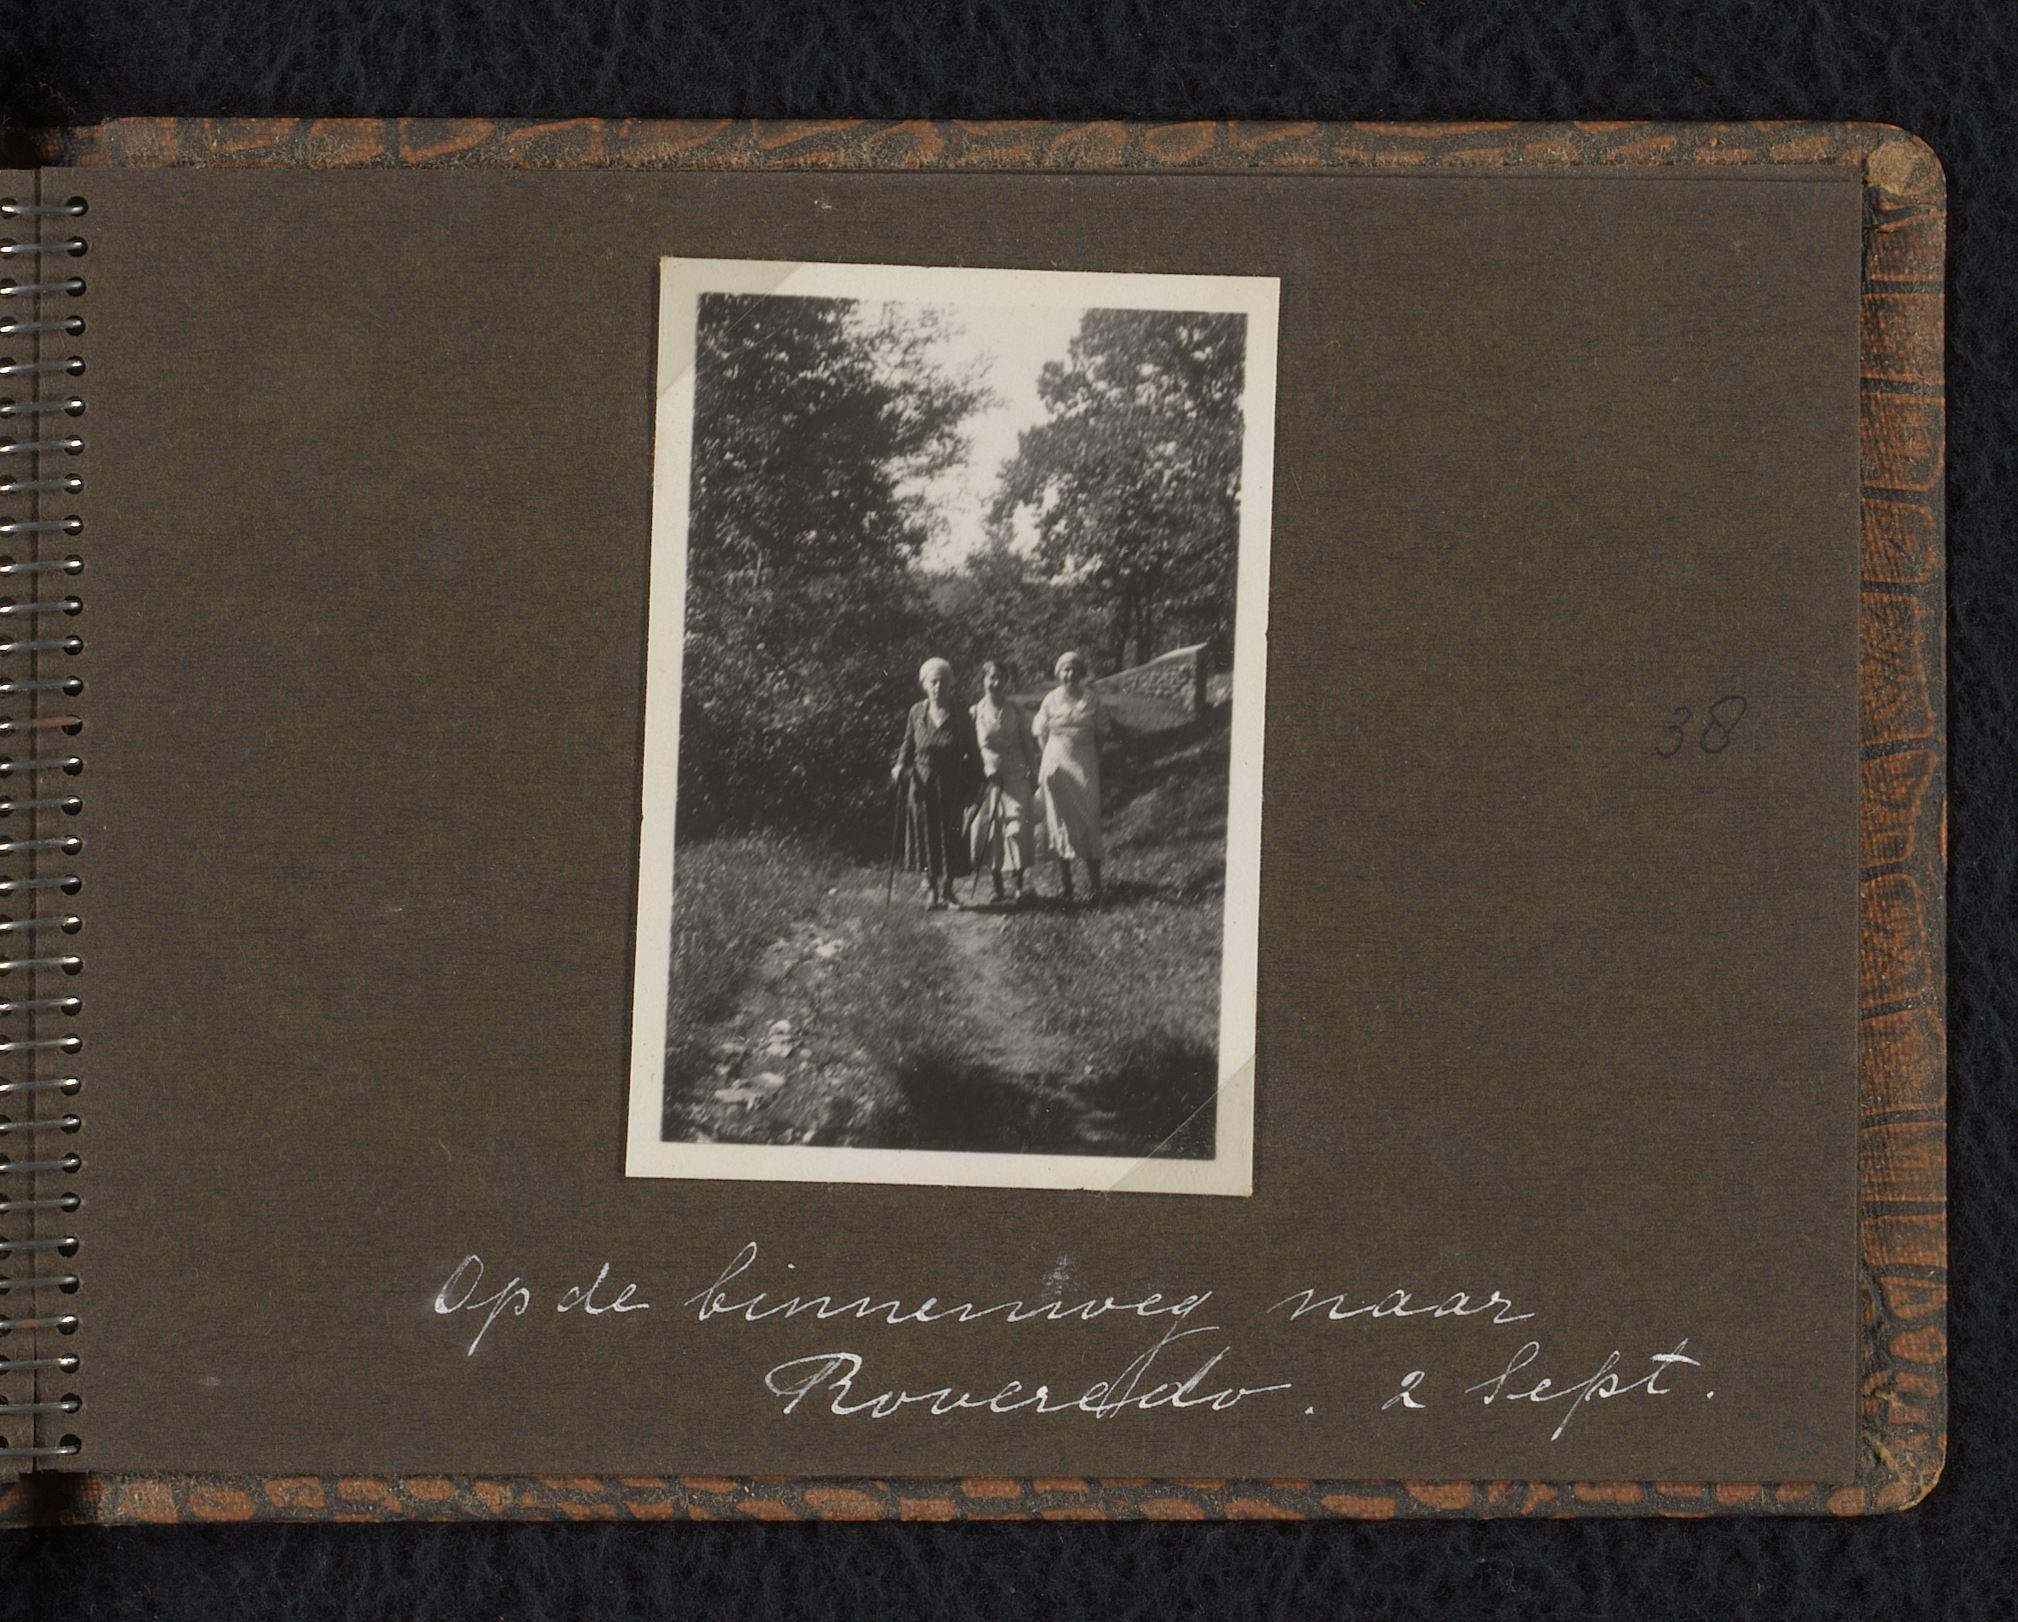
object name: photograph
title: Op de binnenweg naar Roveredo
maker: Anonymous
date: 1934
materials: paper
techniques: gelatin silver print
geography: ticino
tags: walking, hiking (recreation), anonymous historical persons portrayed in a group, in a group-portrait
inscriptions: number: ‘38’